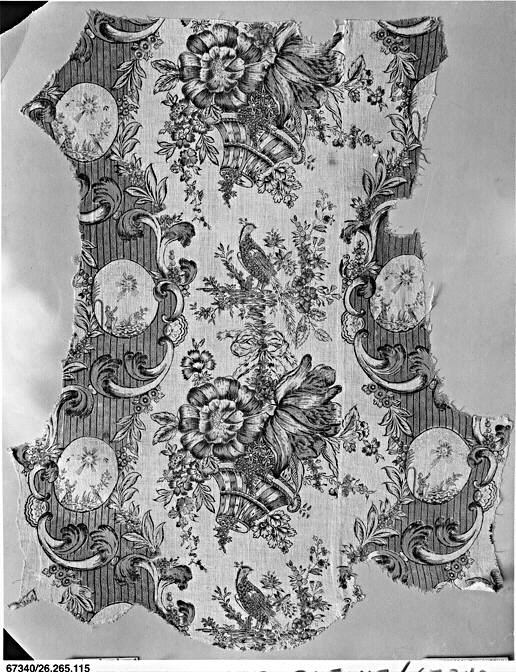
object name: piece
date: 1790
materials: linen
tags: birds,flowers,leaves